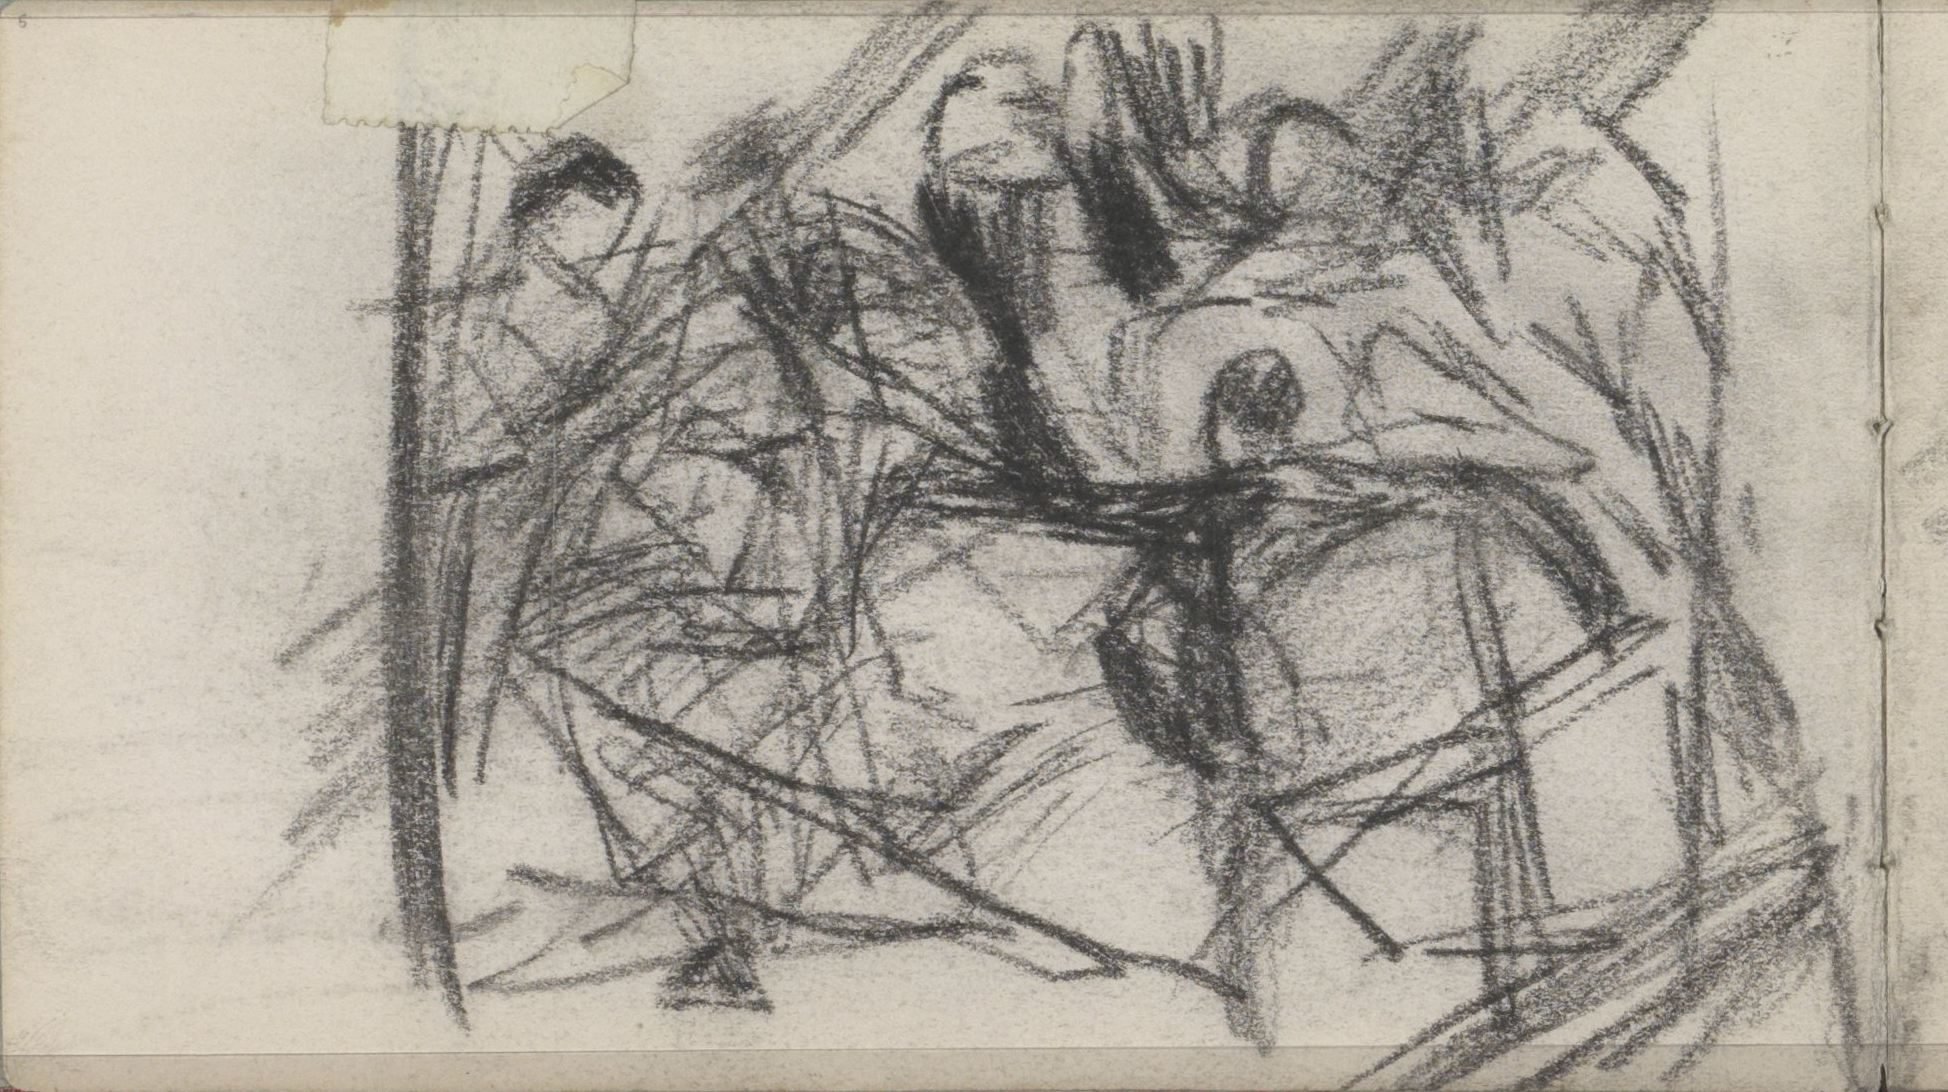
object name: sketchbook leaf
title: Groep figuren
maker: george hendrik breitner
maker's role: draughtsman, painter, print maker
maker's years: 1857-1923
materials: chalk, paper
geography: amsterdam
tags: adult woman, adult man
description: Pagina 5 uit een schetsboek met 32 bladen.